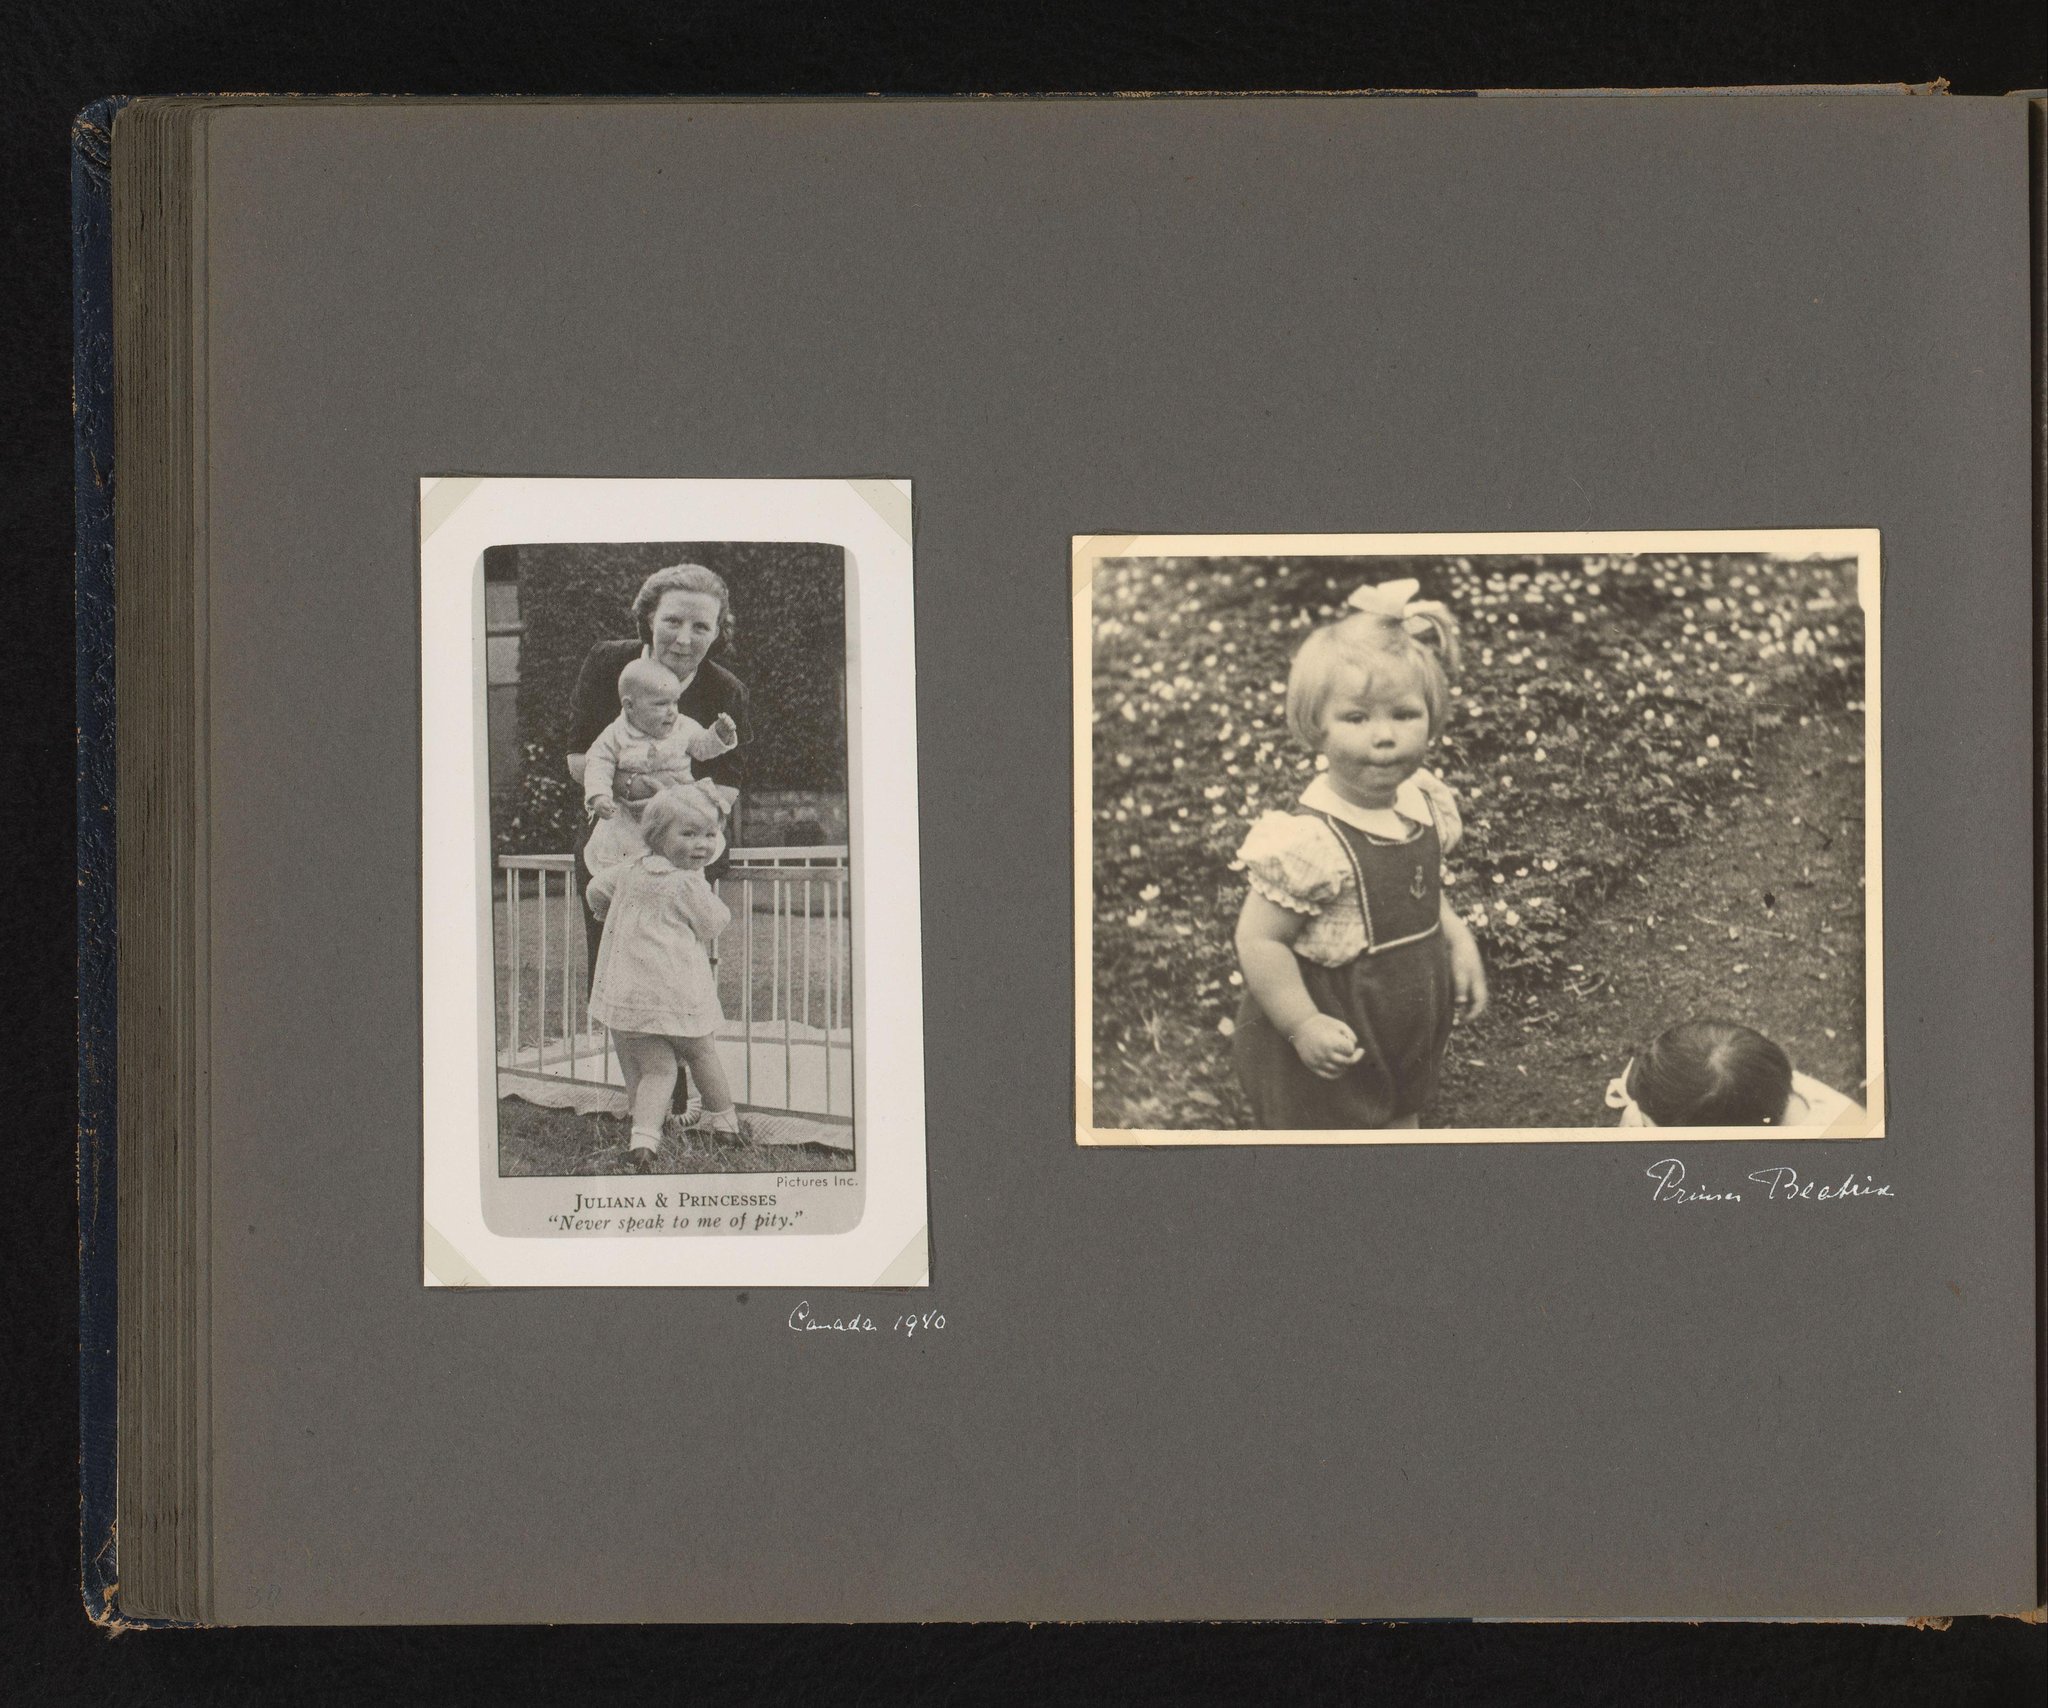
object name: album leaf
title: Juliana met de prinsessen in Canada, 1940-1941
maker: Anonymous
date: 1940-1941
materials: cardboard, photographic support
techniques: gelatin silver print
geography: canada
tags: beatrix (koningin der nederlanden), the hague, juliana of the netherlands, parents with their children, canada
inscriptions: inscription: ‘Canada 1940 / Prinses Beatrix’, inscription: ‘Juliana & Princesses "Never speak to me of pity"’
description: Albumblad met twee foto's van prinses Juliana met de prinsessen Beatrix en Irene in Canada, 1940-1941. Onderdeel van fotoalbum over het familieleven van de leden van het Koninklijk Huis tussen 1937-1945.